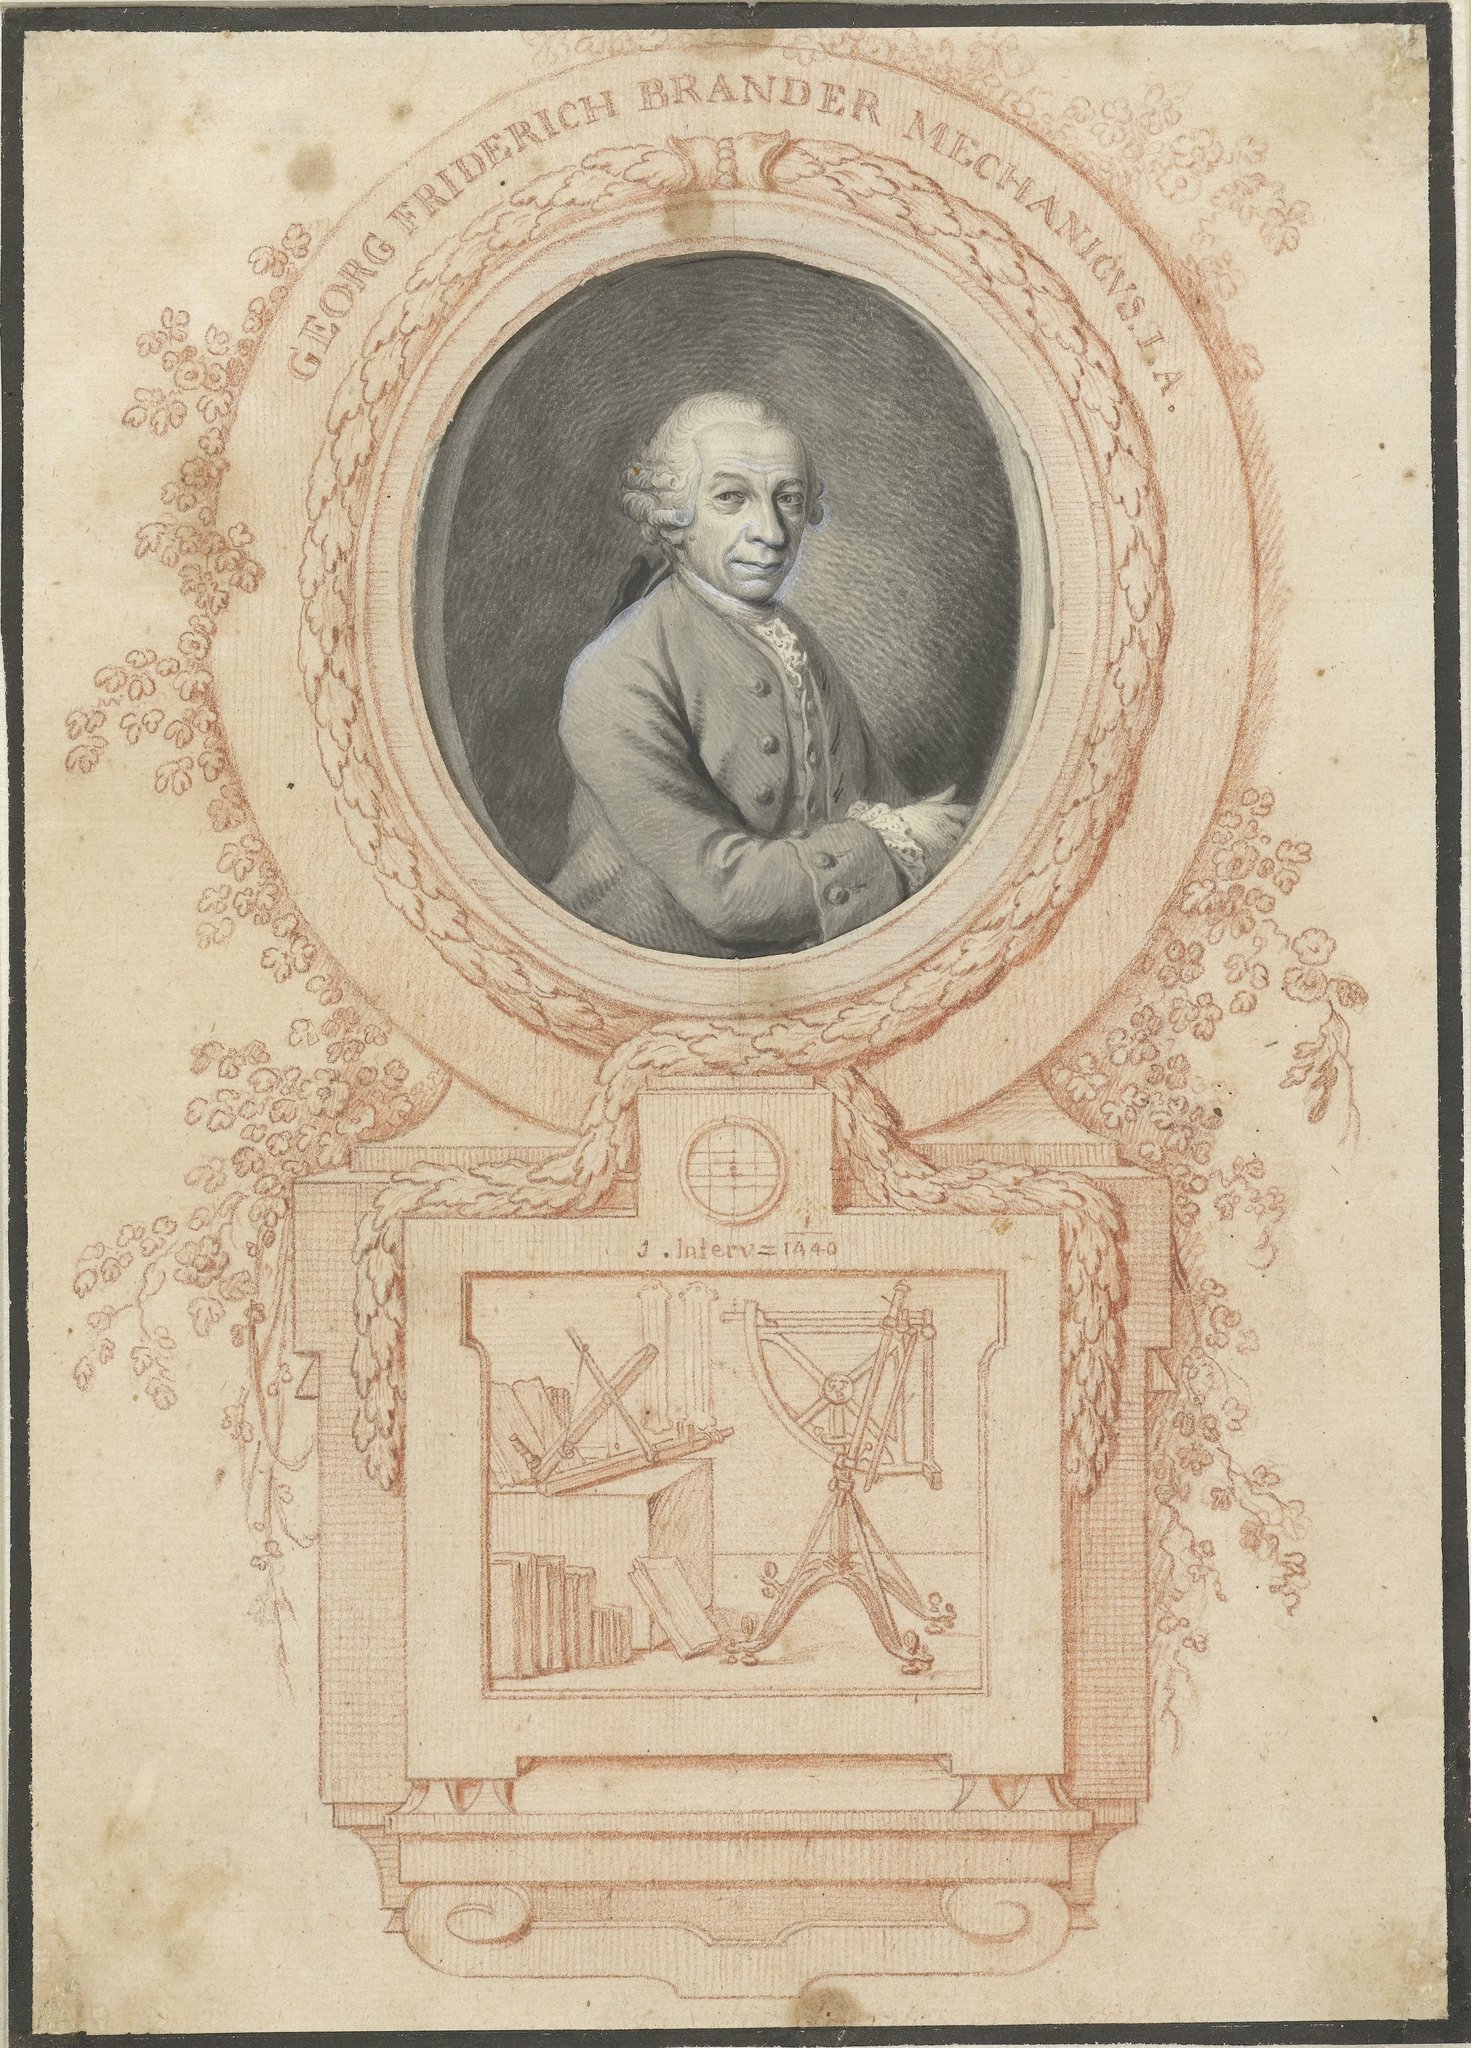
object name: design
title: Portret van Georg Friedrich Brander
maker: johann esaias nilson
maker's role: draughtsman, print maker, publisher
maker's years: 1721-1788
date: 1769-1774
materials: ink, paper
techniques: brush, pen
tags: instrument maker, historical persons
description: Portret van Georg Friedrich Brander, mathematicus te Augsburg. Ontwerp voor een prent.